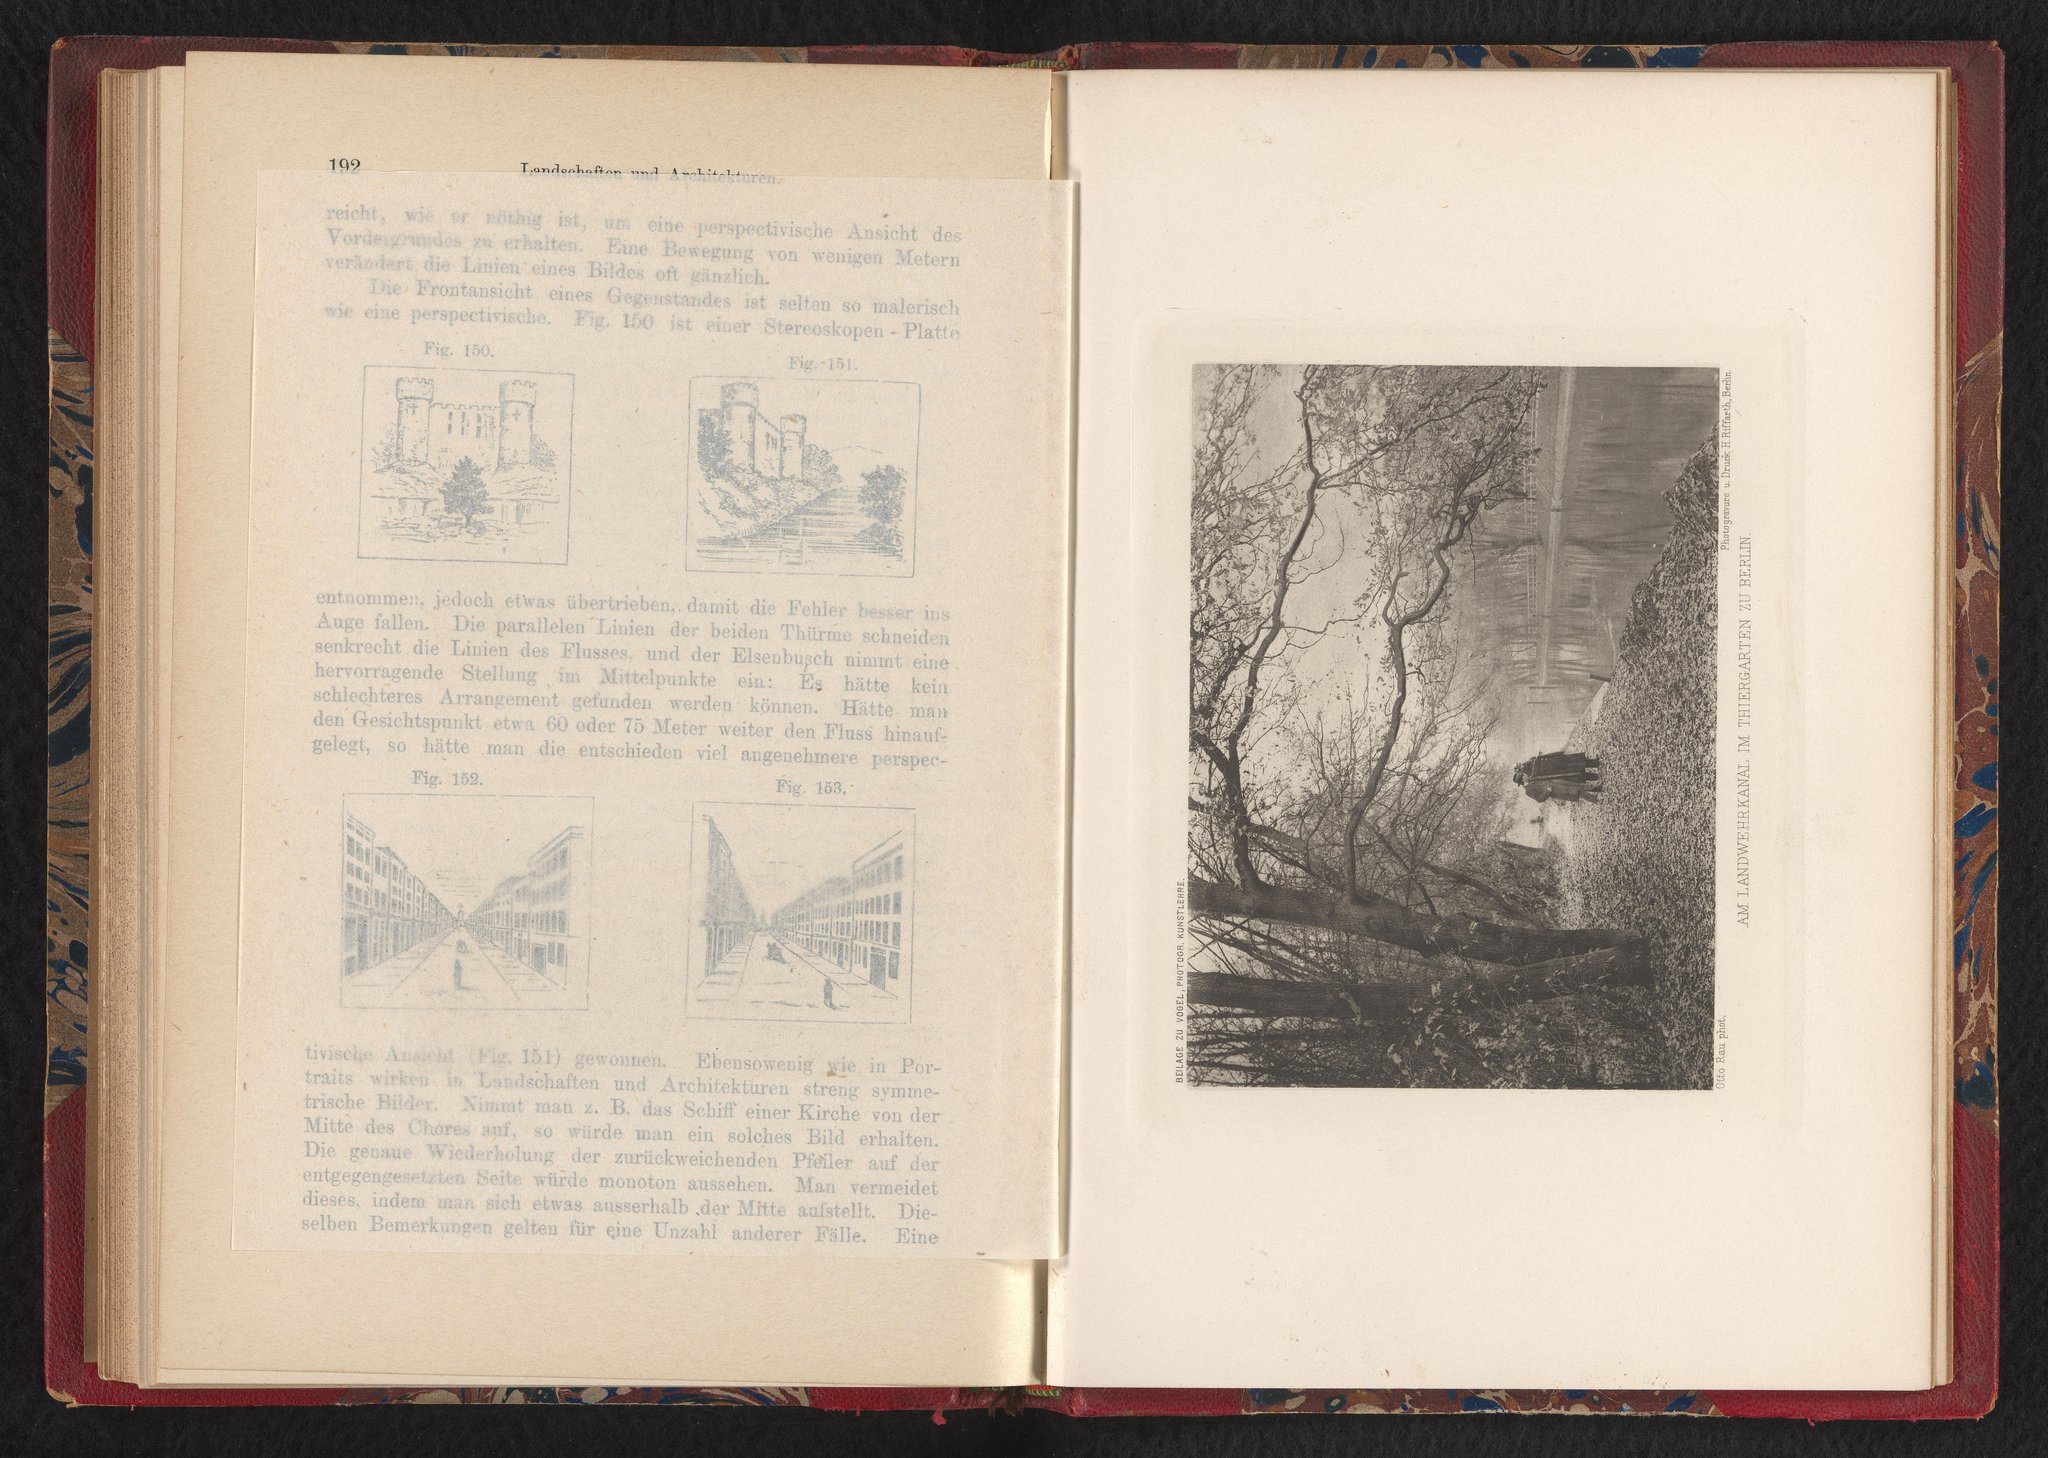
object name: page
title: Twee mensen langs een kanaal in Berlijn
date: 1886-1891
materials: paper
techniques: photoaquatint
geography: berlin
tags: forest, wood, canal (+ landscape with figures, staffage), berlin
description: Prent op ongenummerde pagina tegenover pagina 192.